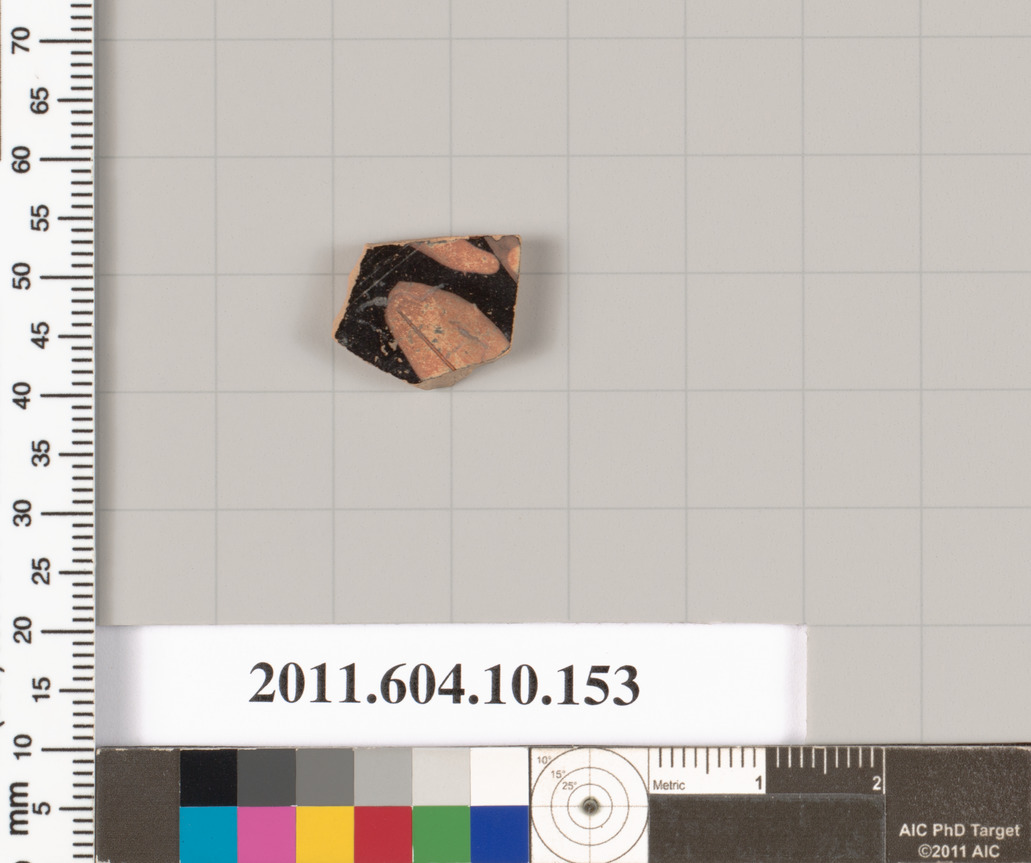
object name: skyphos fragment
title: Terracotta fragment of a skyphos (deep drinking cup)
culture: etruscan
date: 434-401 BCE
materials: terracotta